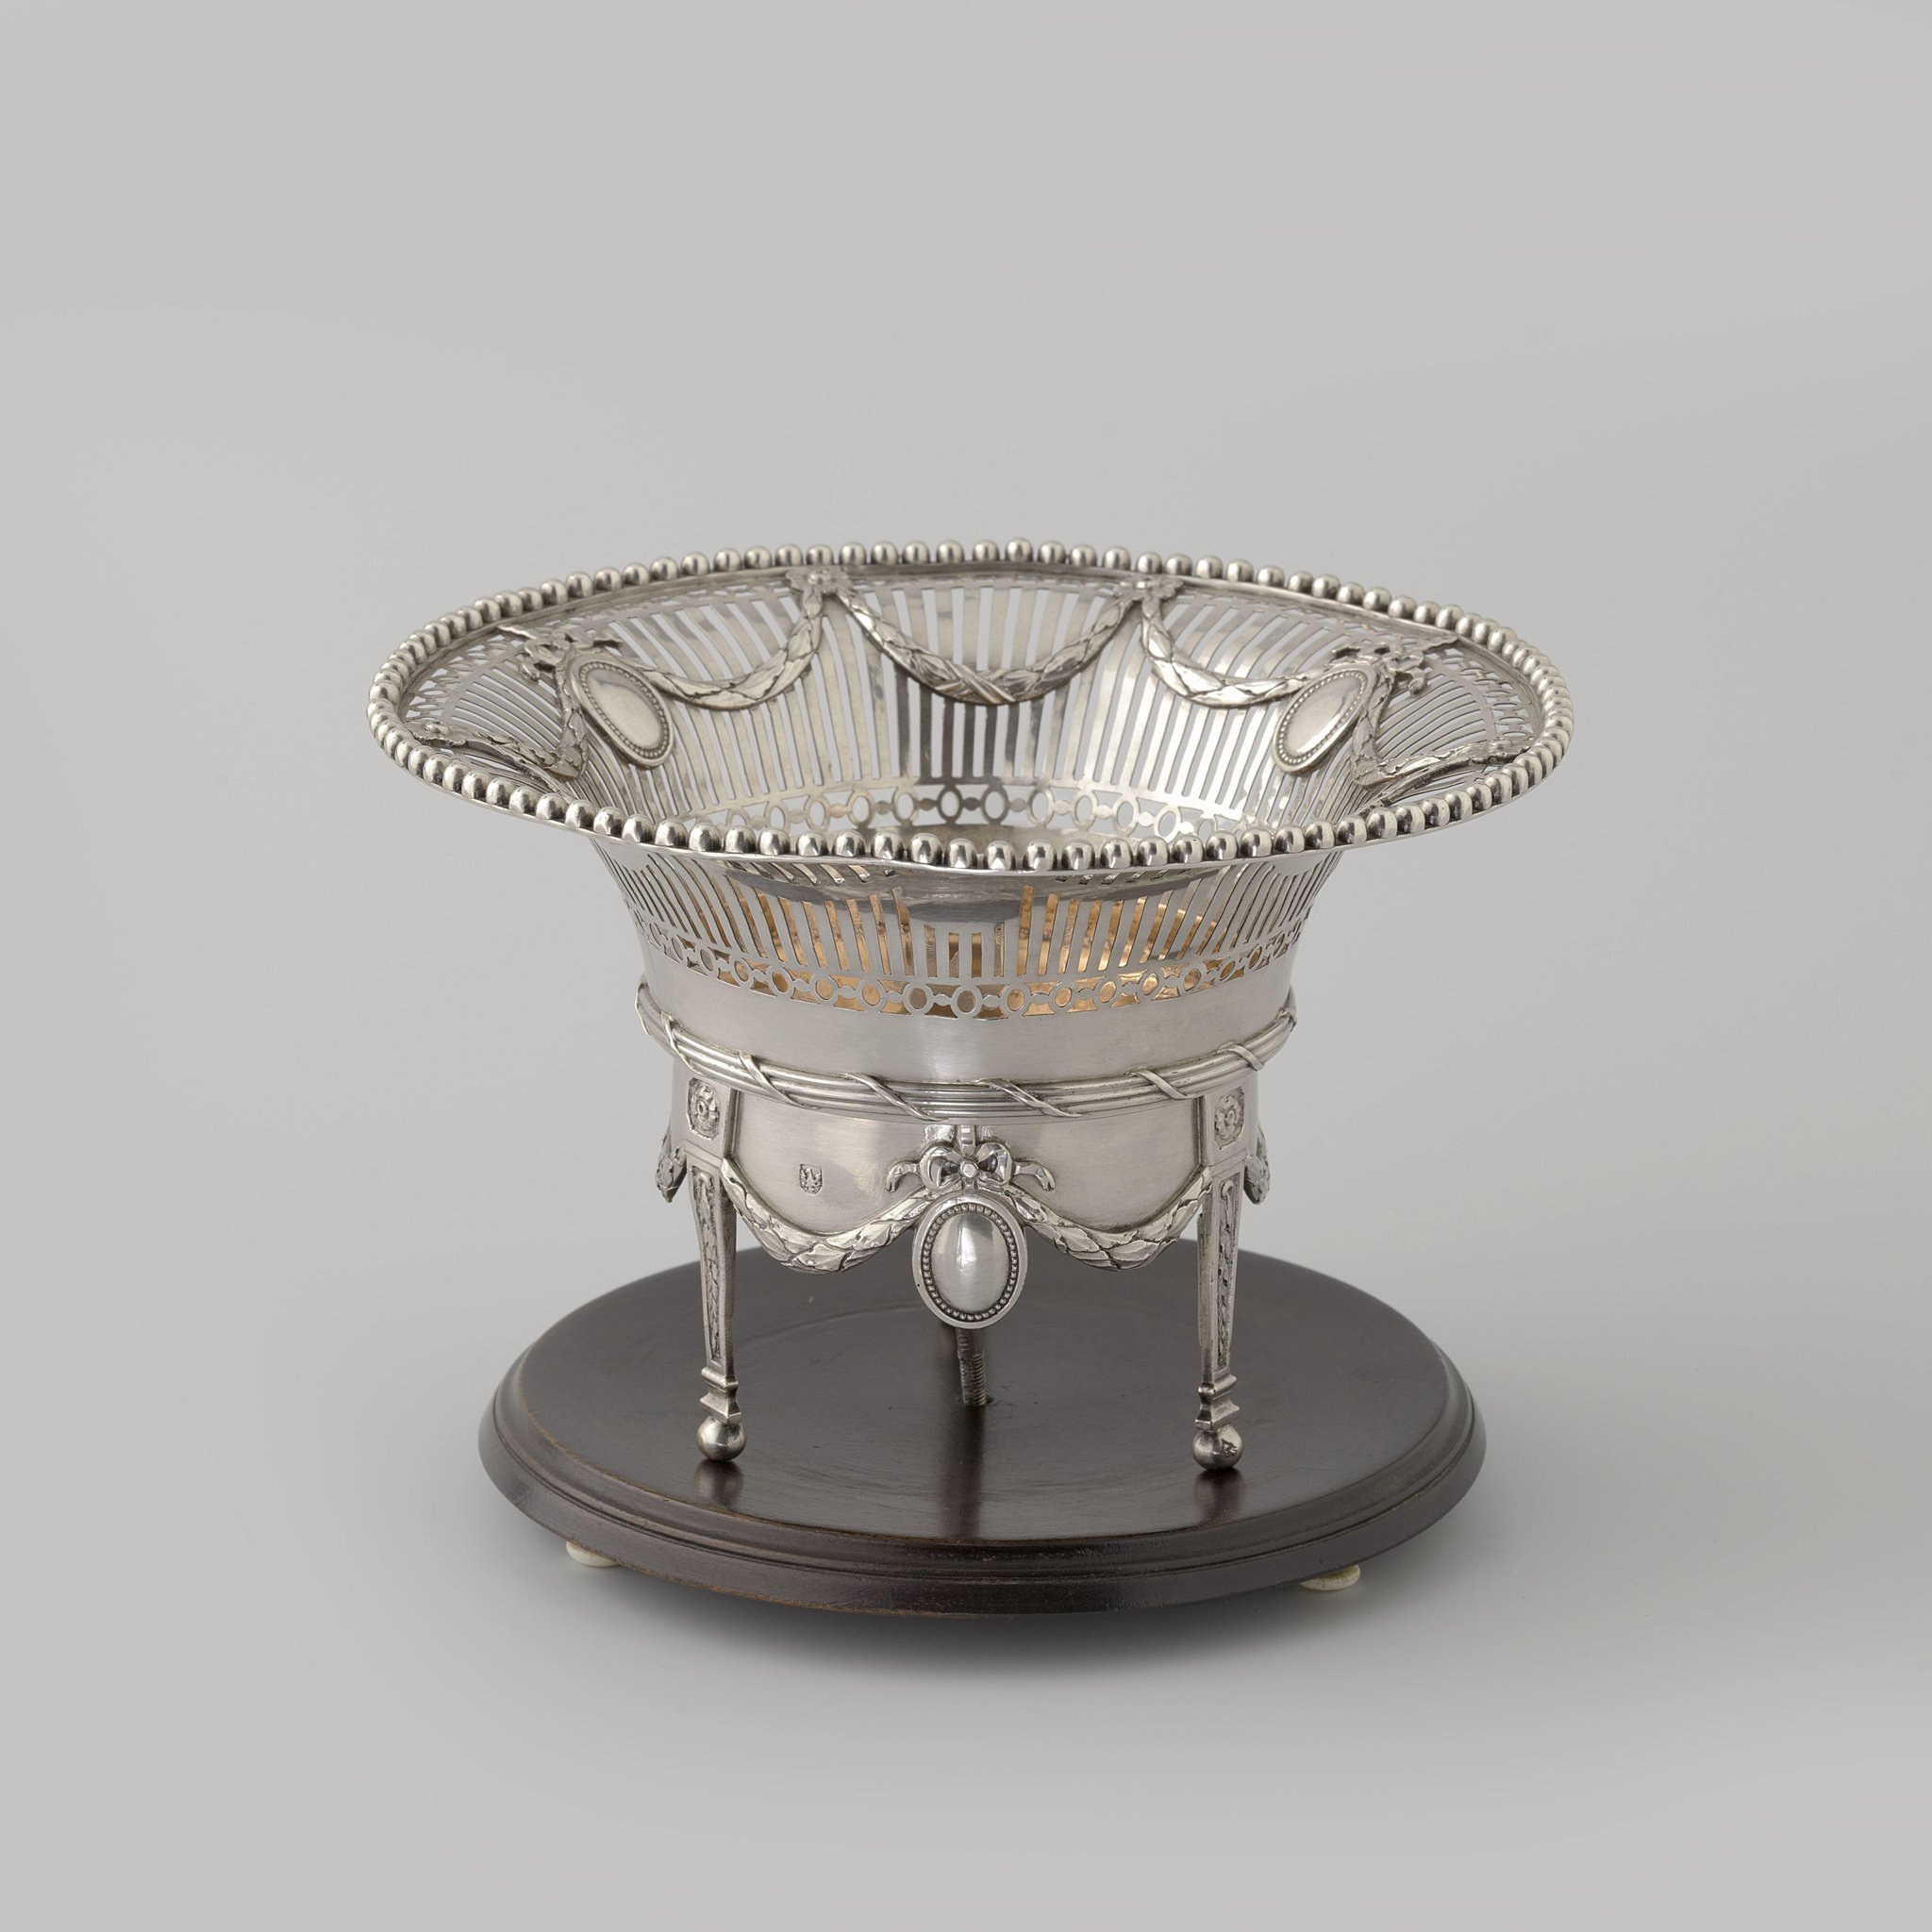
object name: forgery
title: Komfoor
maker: frederik august ernst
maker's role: silversmith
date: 1787-1804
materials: wood, silver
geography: deventer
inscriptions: date letter: ‘G? (Niet vermeld bij Ter Molen 1997)’, maker's mark: ‘FAE (Ter Molen 1997 p. 203)’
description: Komfoor van zilver op drie pootjes, staande op een ebbenhouten blad. Aan de boven- en onderkant geappliqueerde guirlandes met drie ovale medaillons hangende aan strikken. Meesterteken: FAE of FAB.